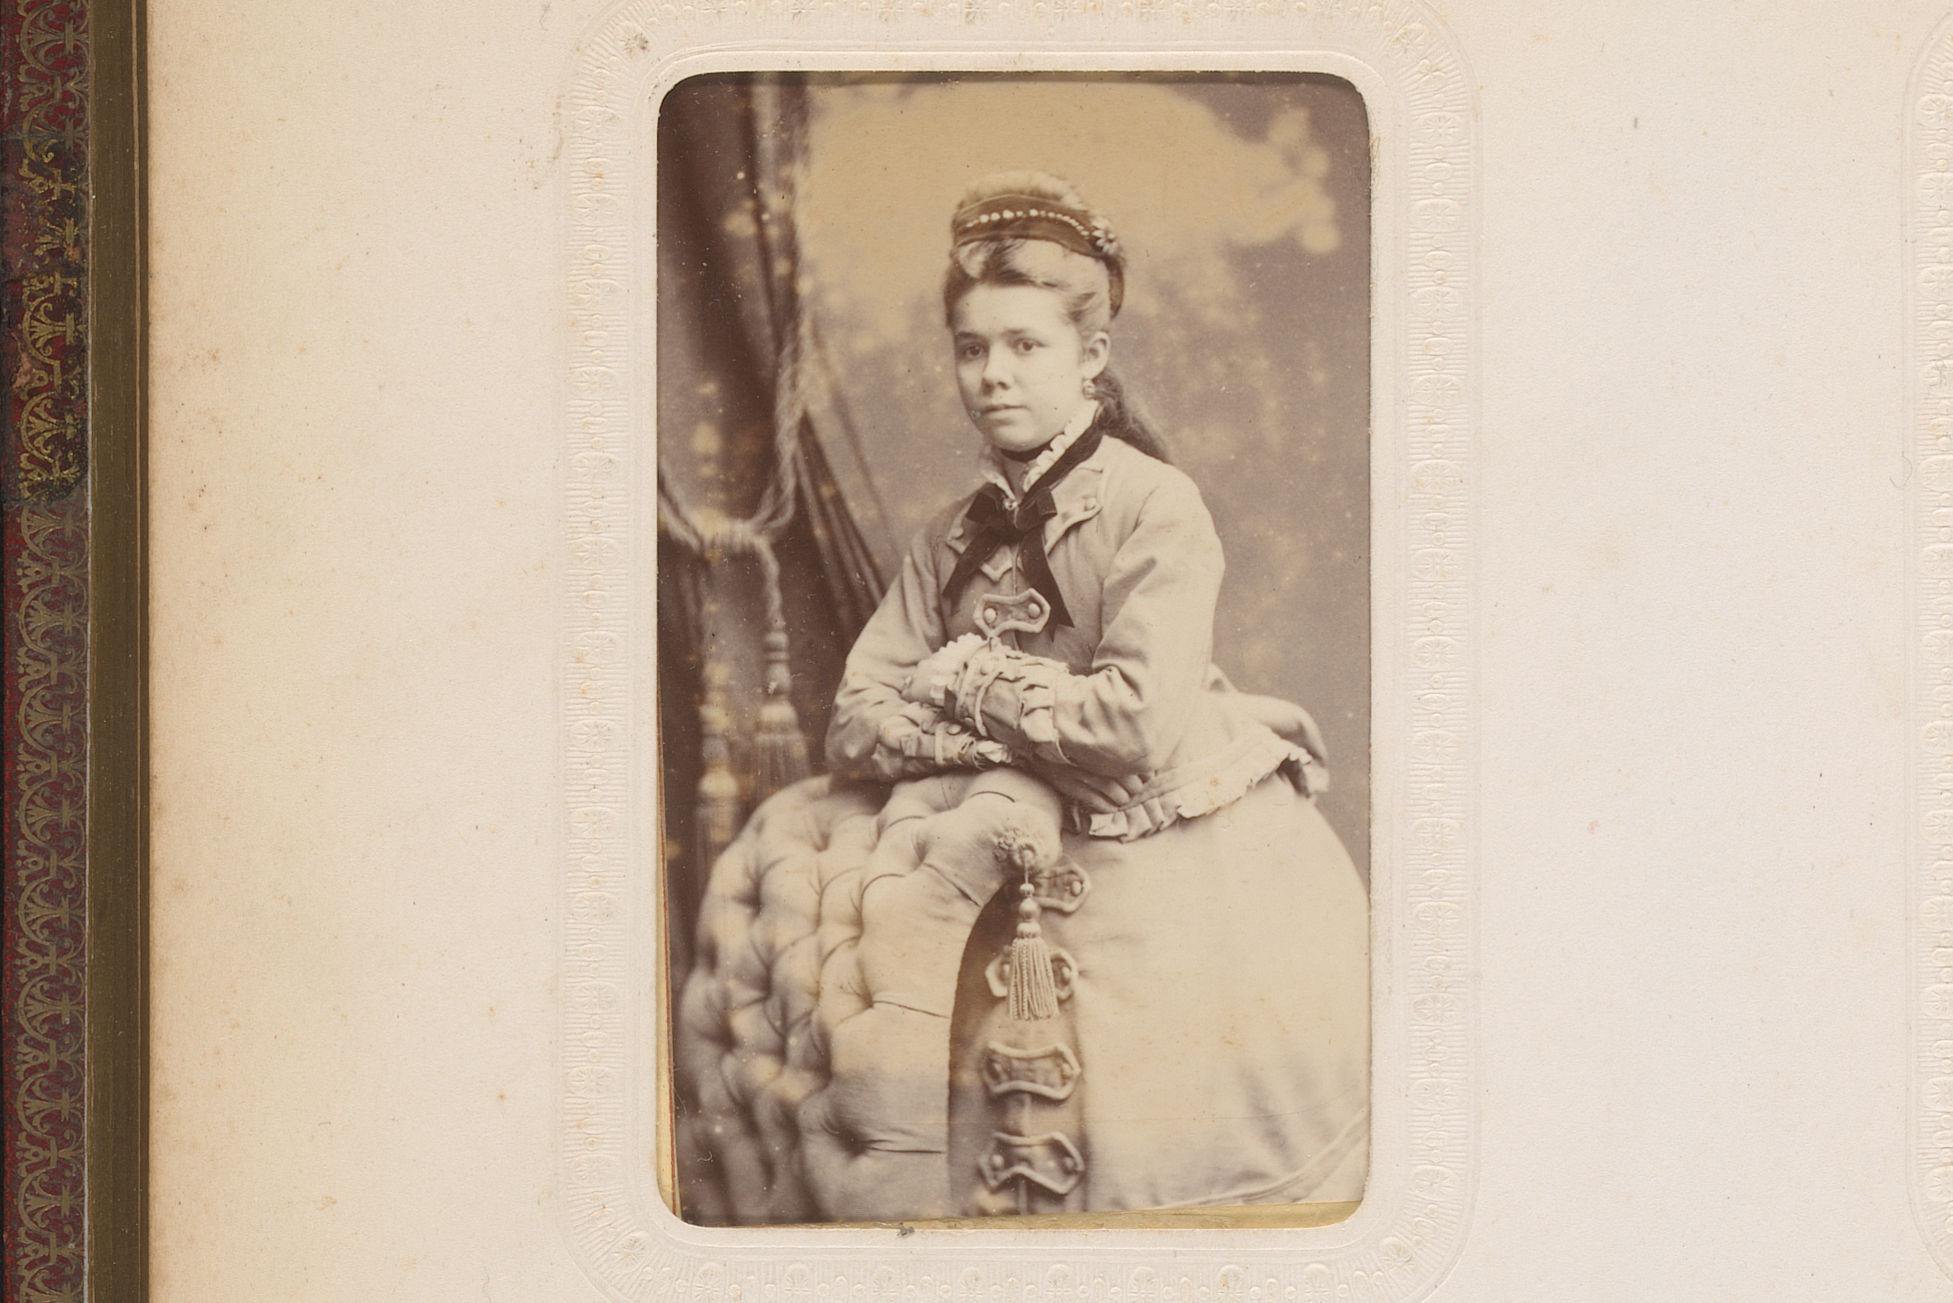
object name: album leaf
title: Portret van een staande jonge vrouw, leunend op de leuning van een stoel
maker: Anonymous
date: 1860-1900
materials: cardboard, photographic support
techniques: albumen print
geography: netherlands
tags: adolescent, young woman, maiden, historical persons - bb - woman, standing figure - aa - female human figure, chair